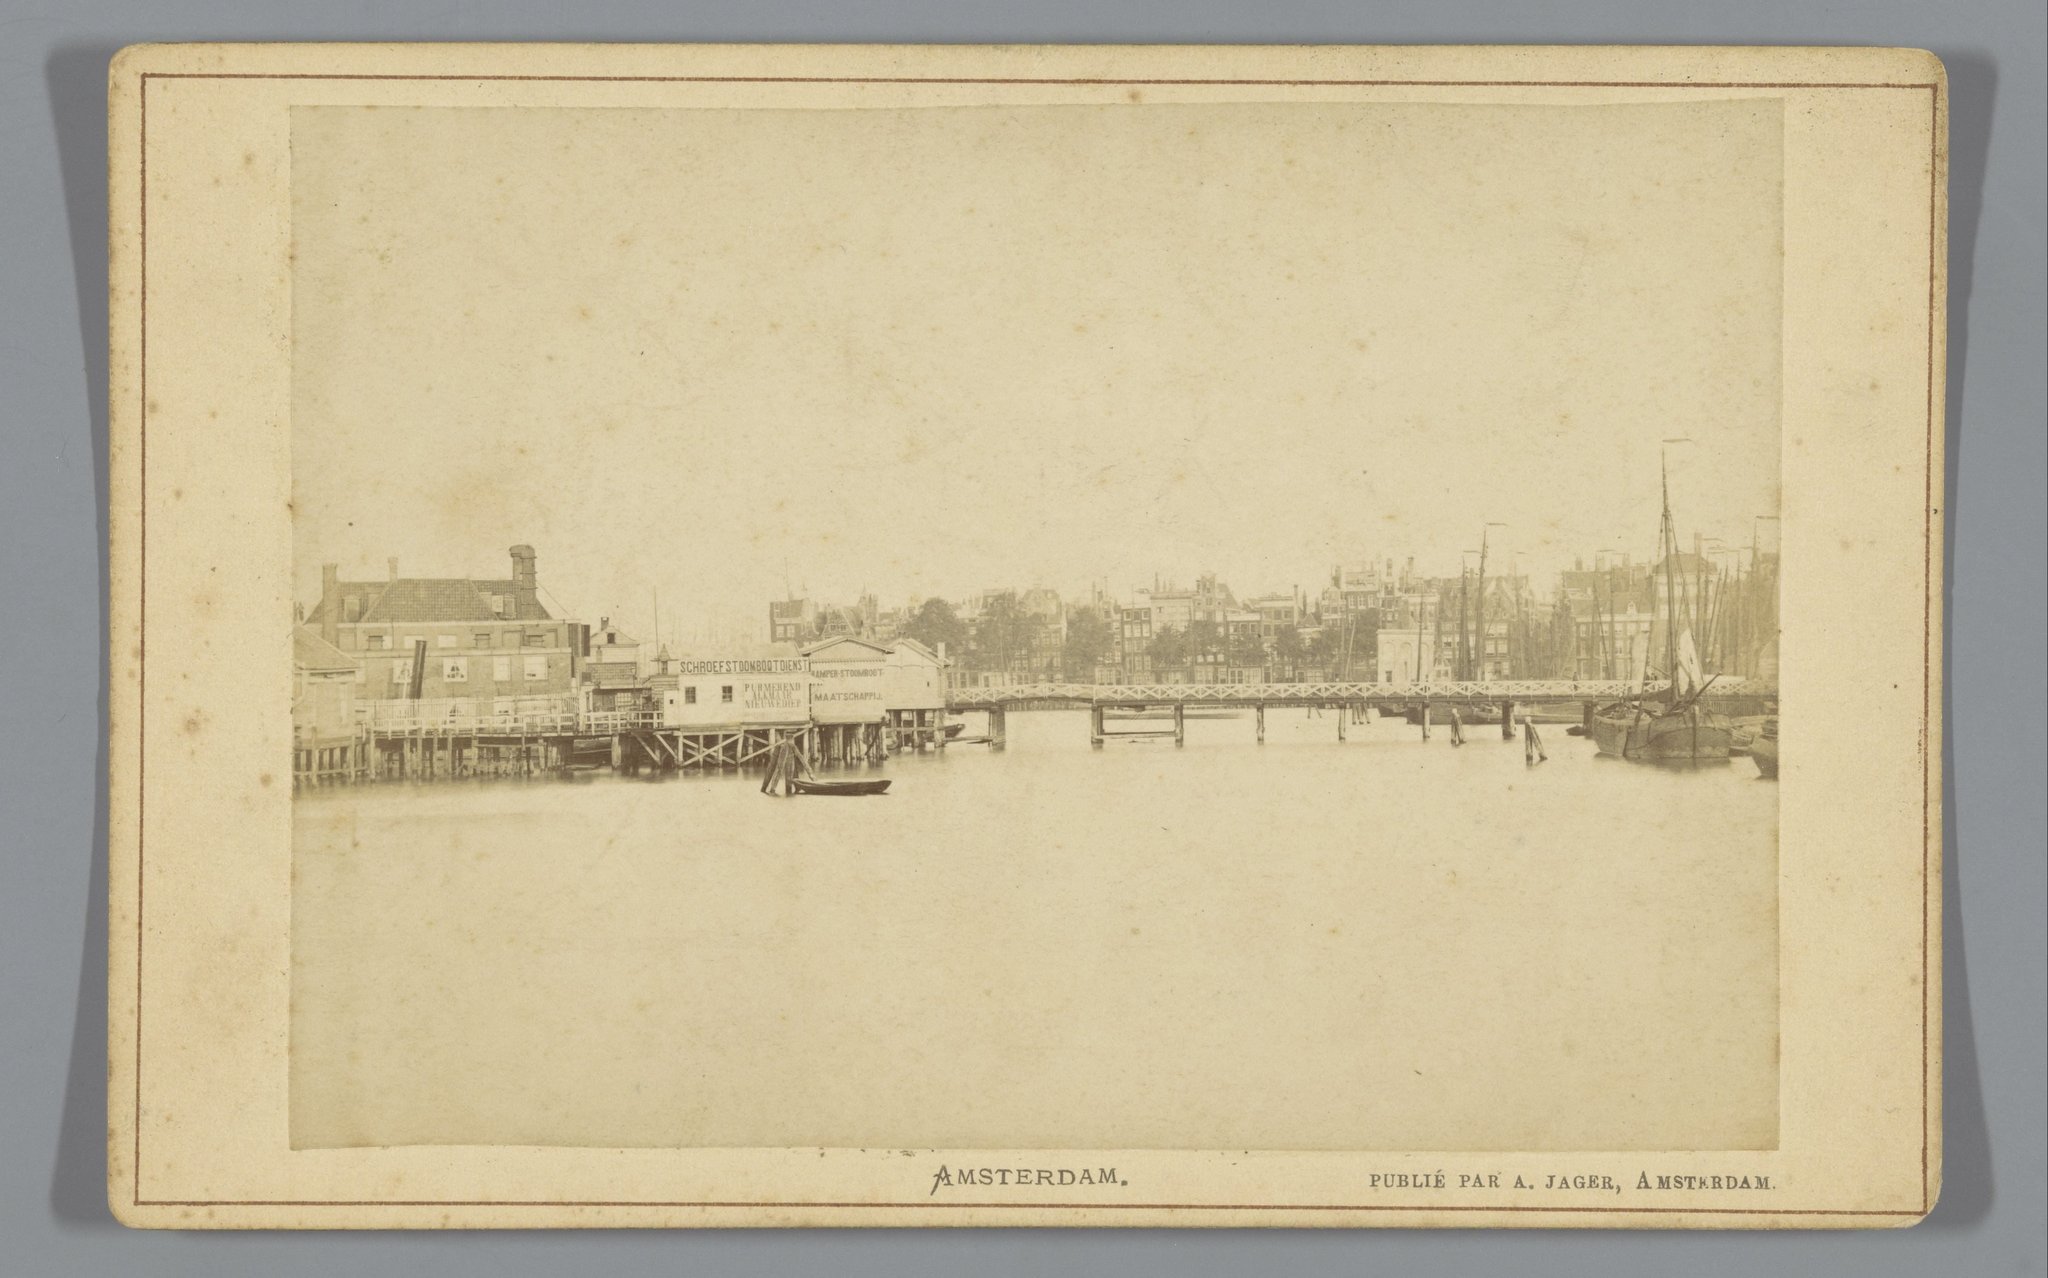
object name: cabinet photograph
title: Gezicht op de Nieuwe Stadsherberg en het IJ in Amsterdam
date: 1860-1876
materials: cardboard, photographic support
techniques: albumen print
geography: amsterdam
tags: canals, waters (in city), hotel, hostelry, inn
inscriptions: annotation: ‘Nieuwe Stadsherberg-’